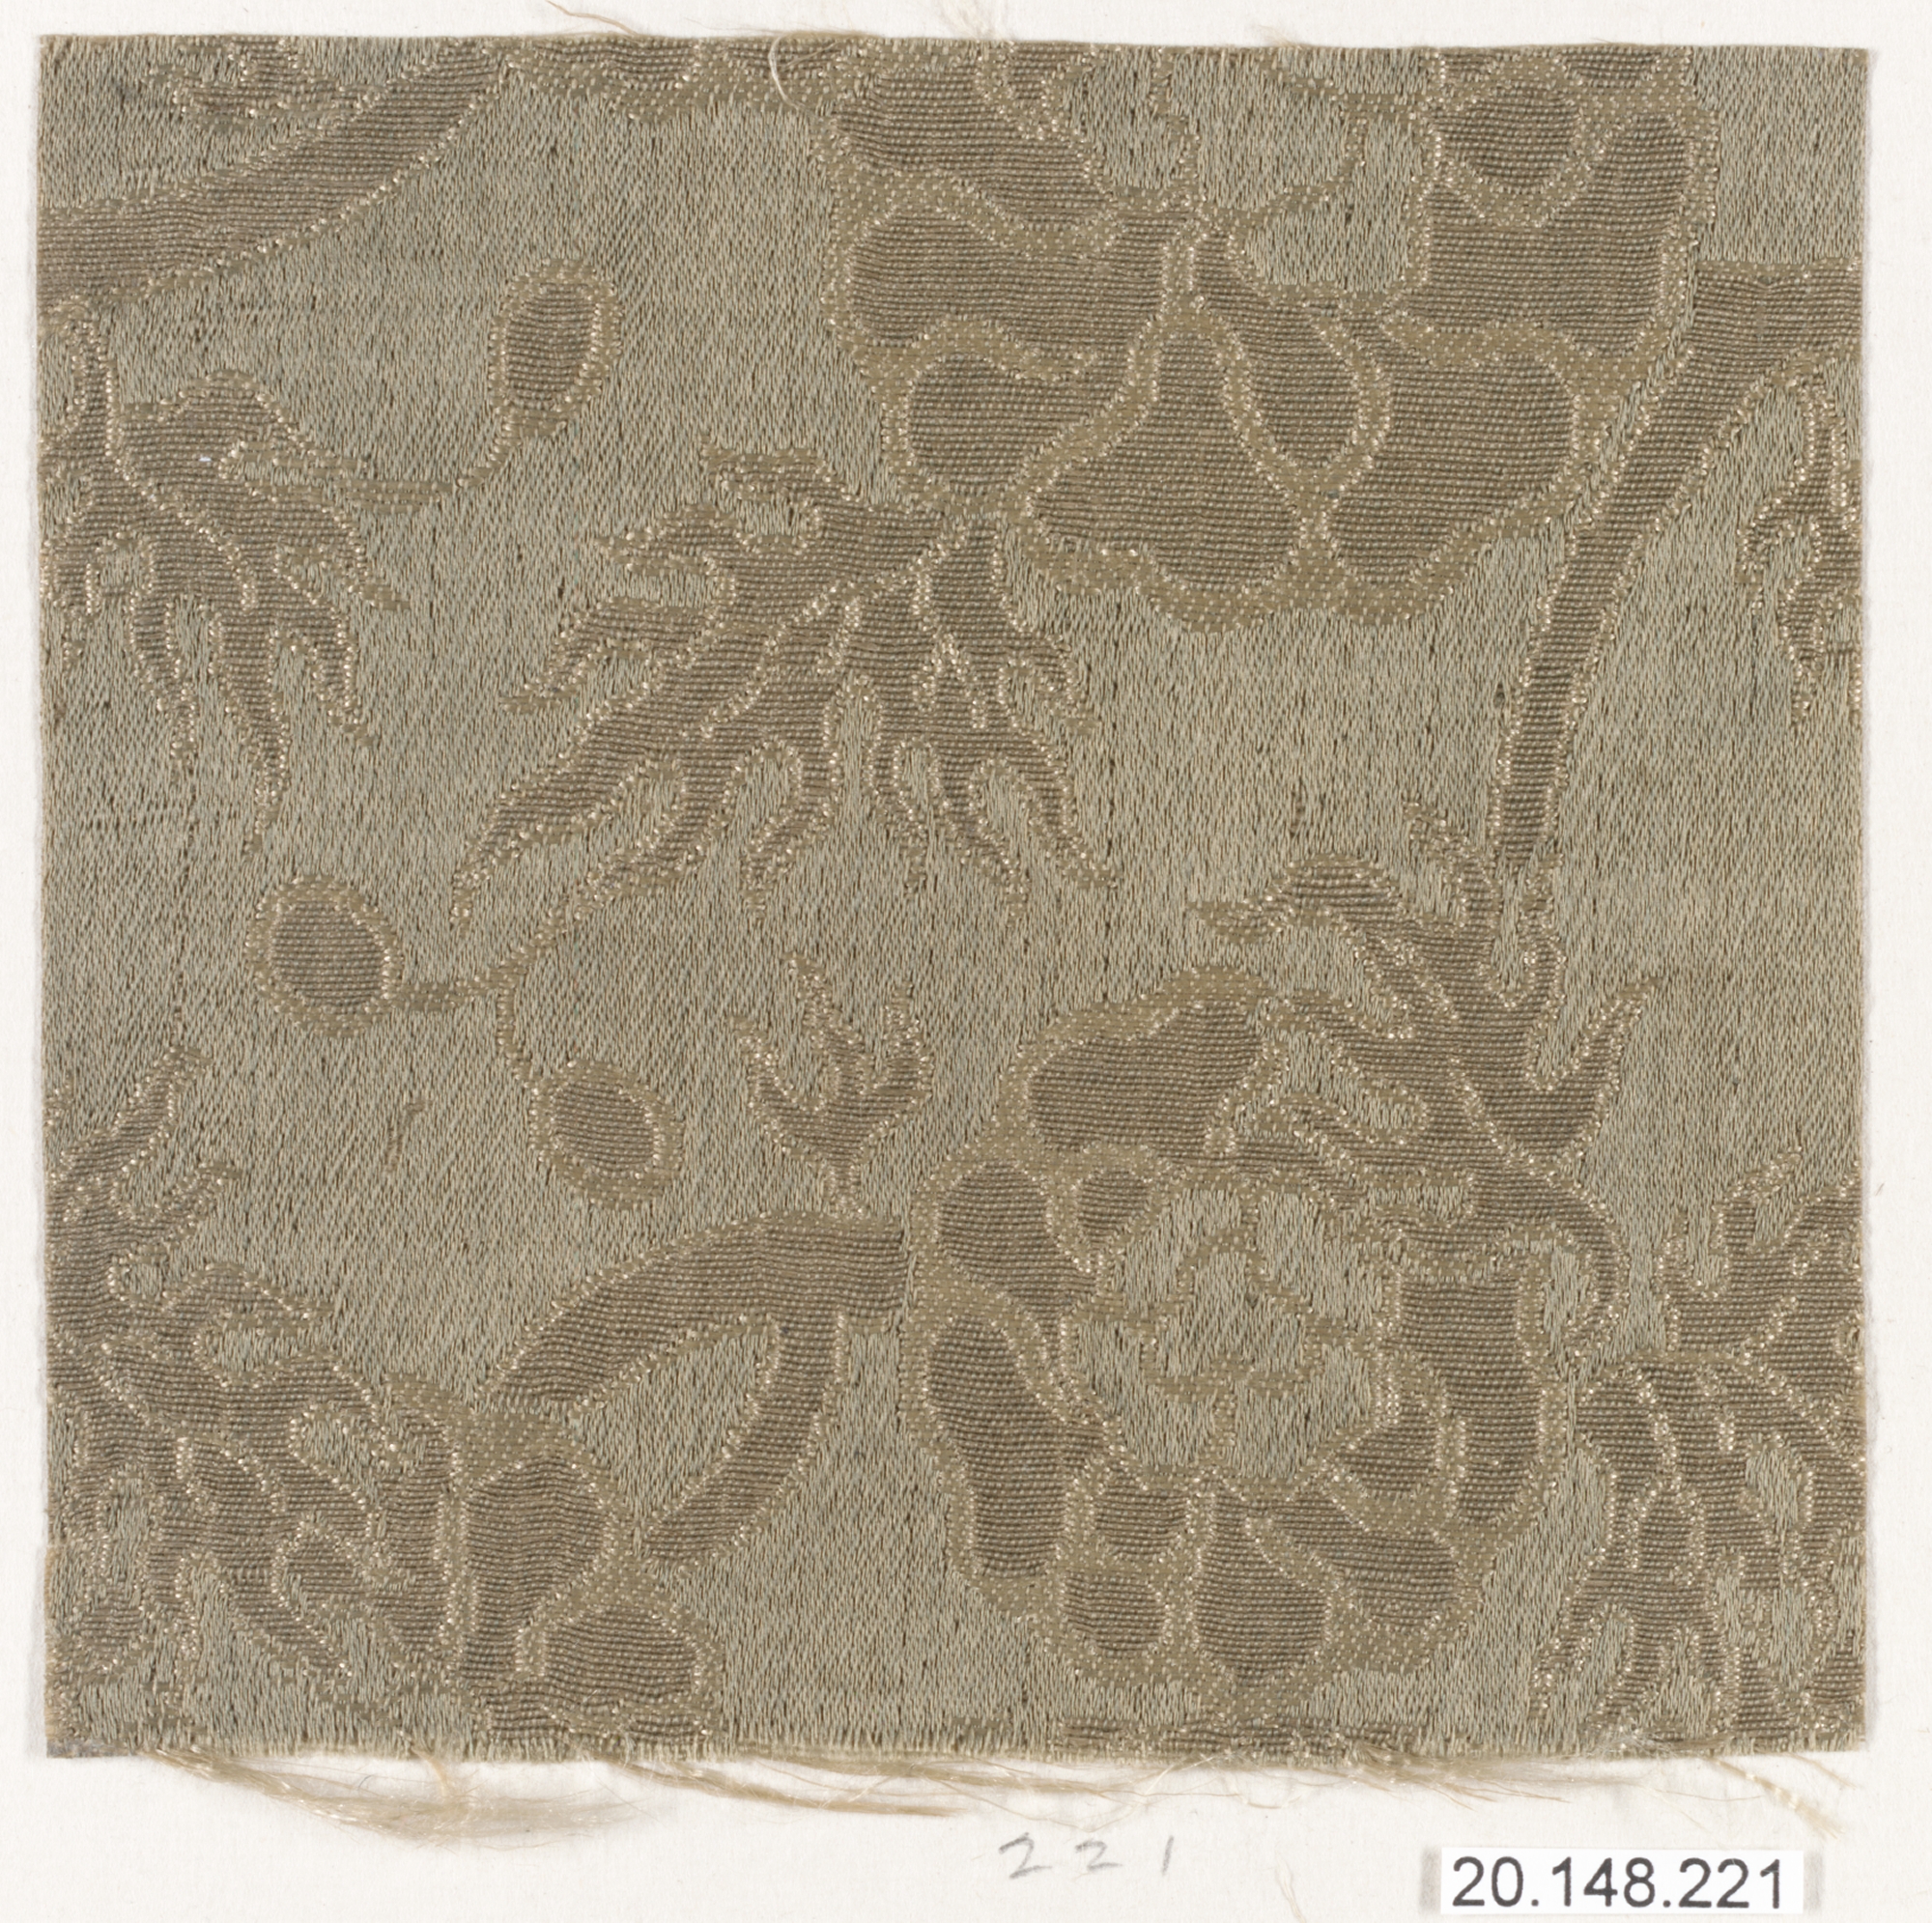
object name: piece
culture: japanese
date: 1701-1800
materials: silk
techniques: compound weave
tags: flowers